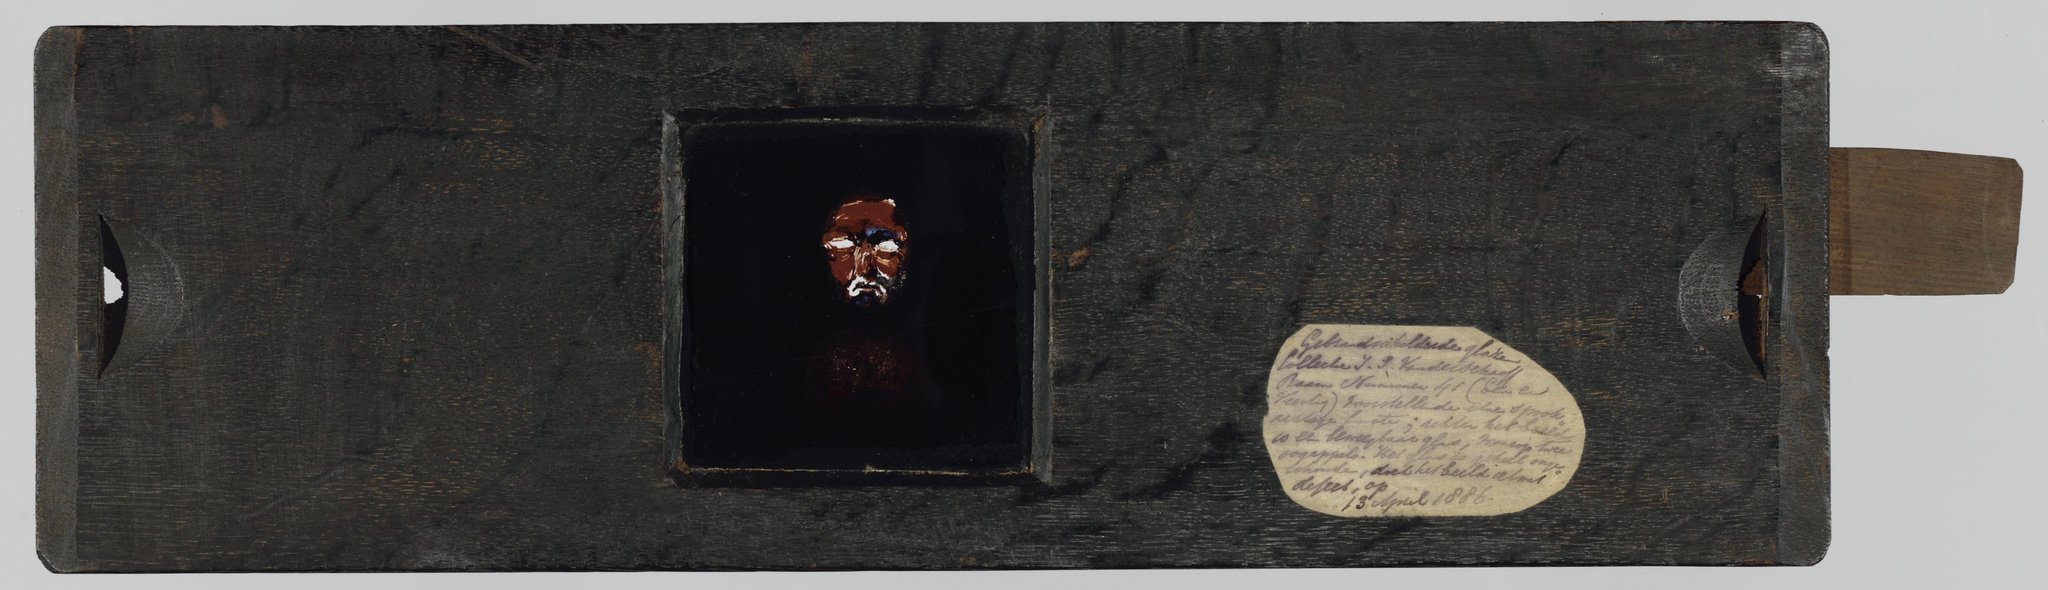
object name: lantern slide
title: Beweegbare plaat van angtaanjagend gezicht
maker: Anonymous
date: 1790-1830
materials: glass, wood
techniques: painted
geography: netherlands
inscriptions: label: ‘'Gebrandschilderde glazen. Collectie I.S. van der Schaaff, Baarn. Nummer 41 (éénenveertig) bevattende één glas, voorstellende een spookbuste. Achter het glas is beweegbaar glas, waarop twee oogappels zichtbaar zijn. Het glas is geheel ongeschonden en gaaf op 13 april 1886.'’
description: Vierkante glasplaat in houten vatting. Beweegbare plaat van een rood, kwaad kijkend gezicht van voren gezien. De pupillen van de ogen zijn op een los glasplaatje geschilderd dat met een schuifje kan worden bewogen. De achtergrond is zwart.